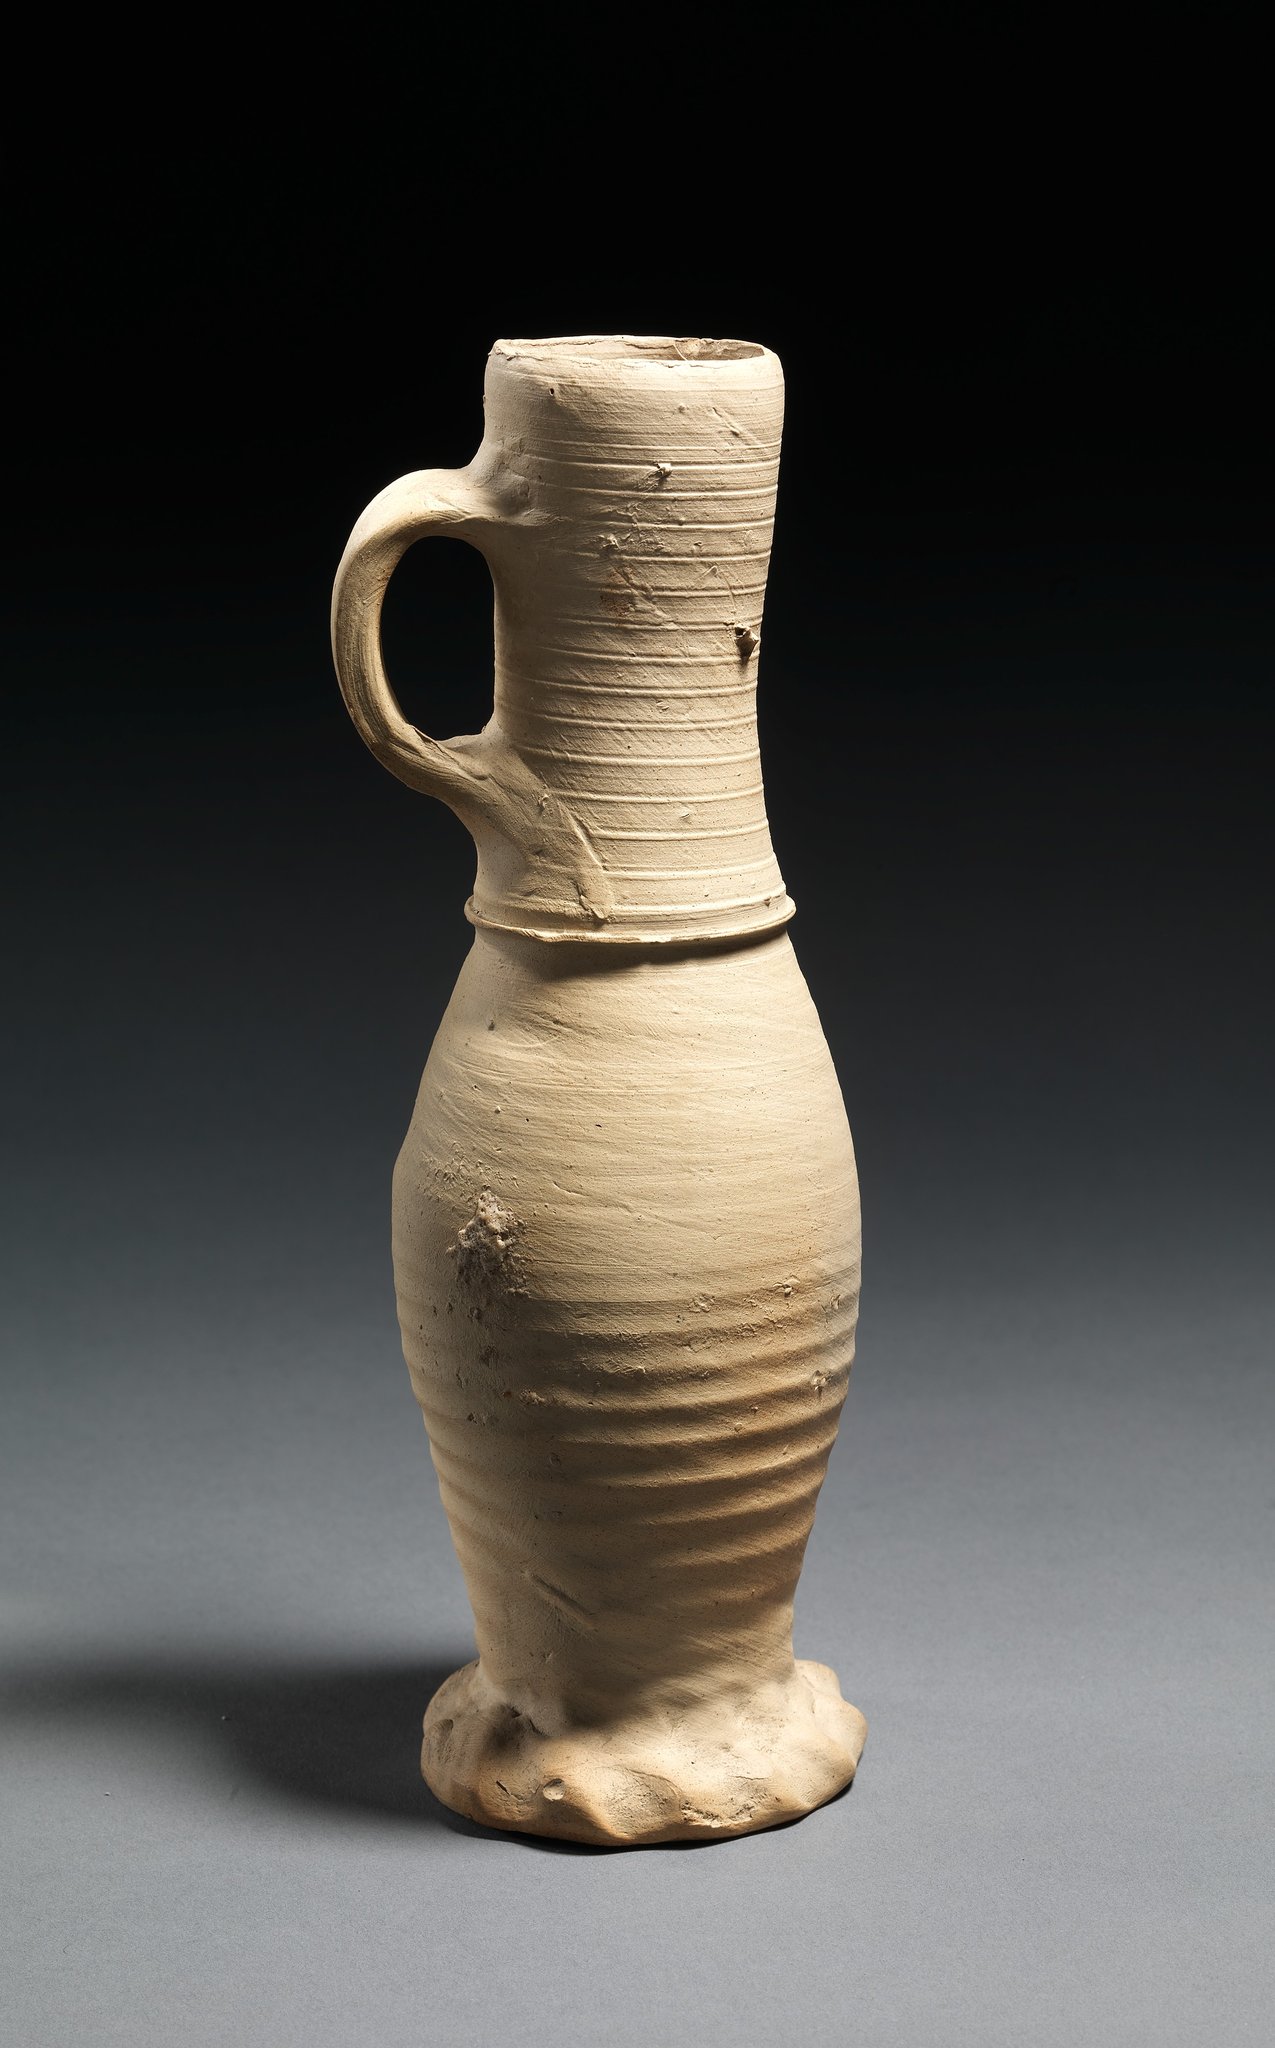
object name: jug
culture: german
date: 1367-1433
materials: stoneware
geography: germany